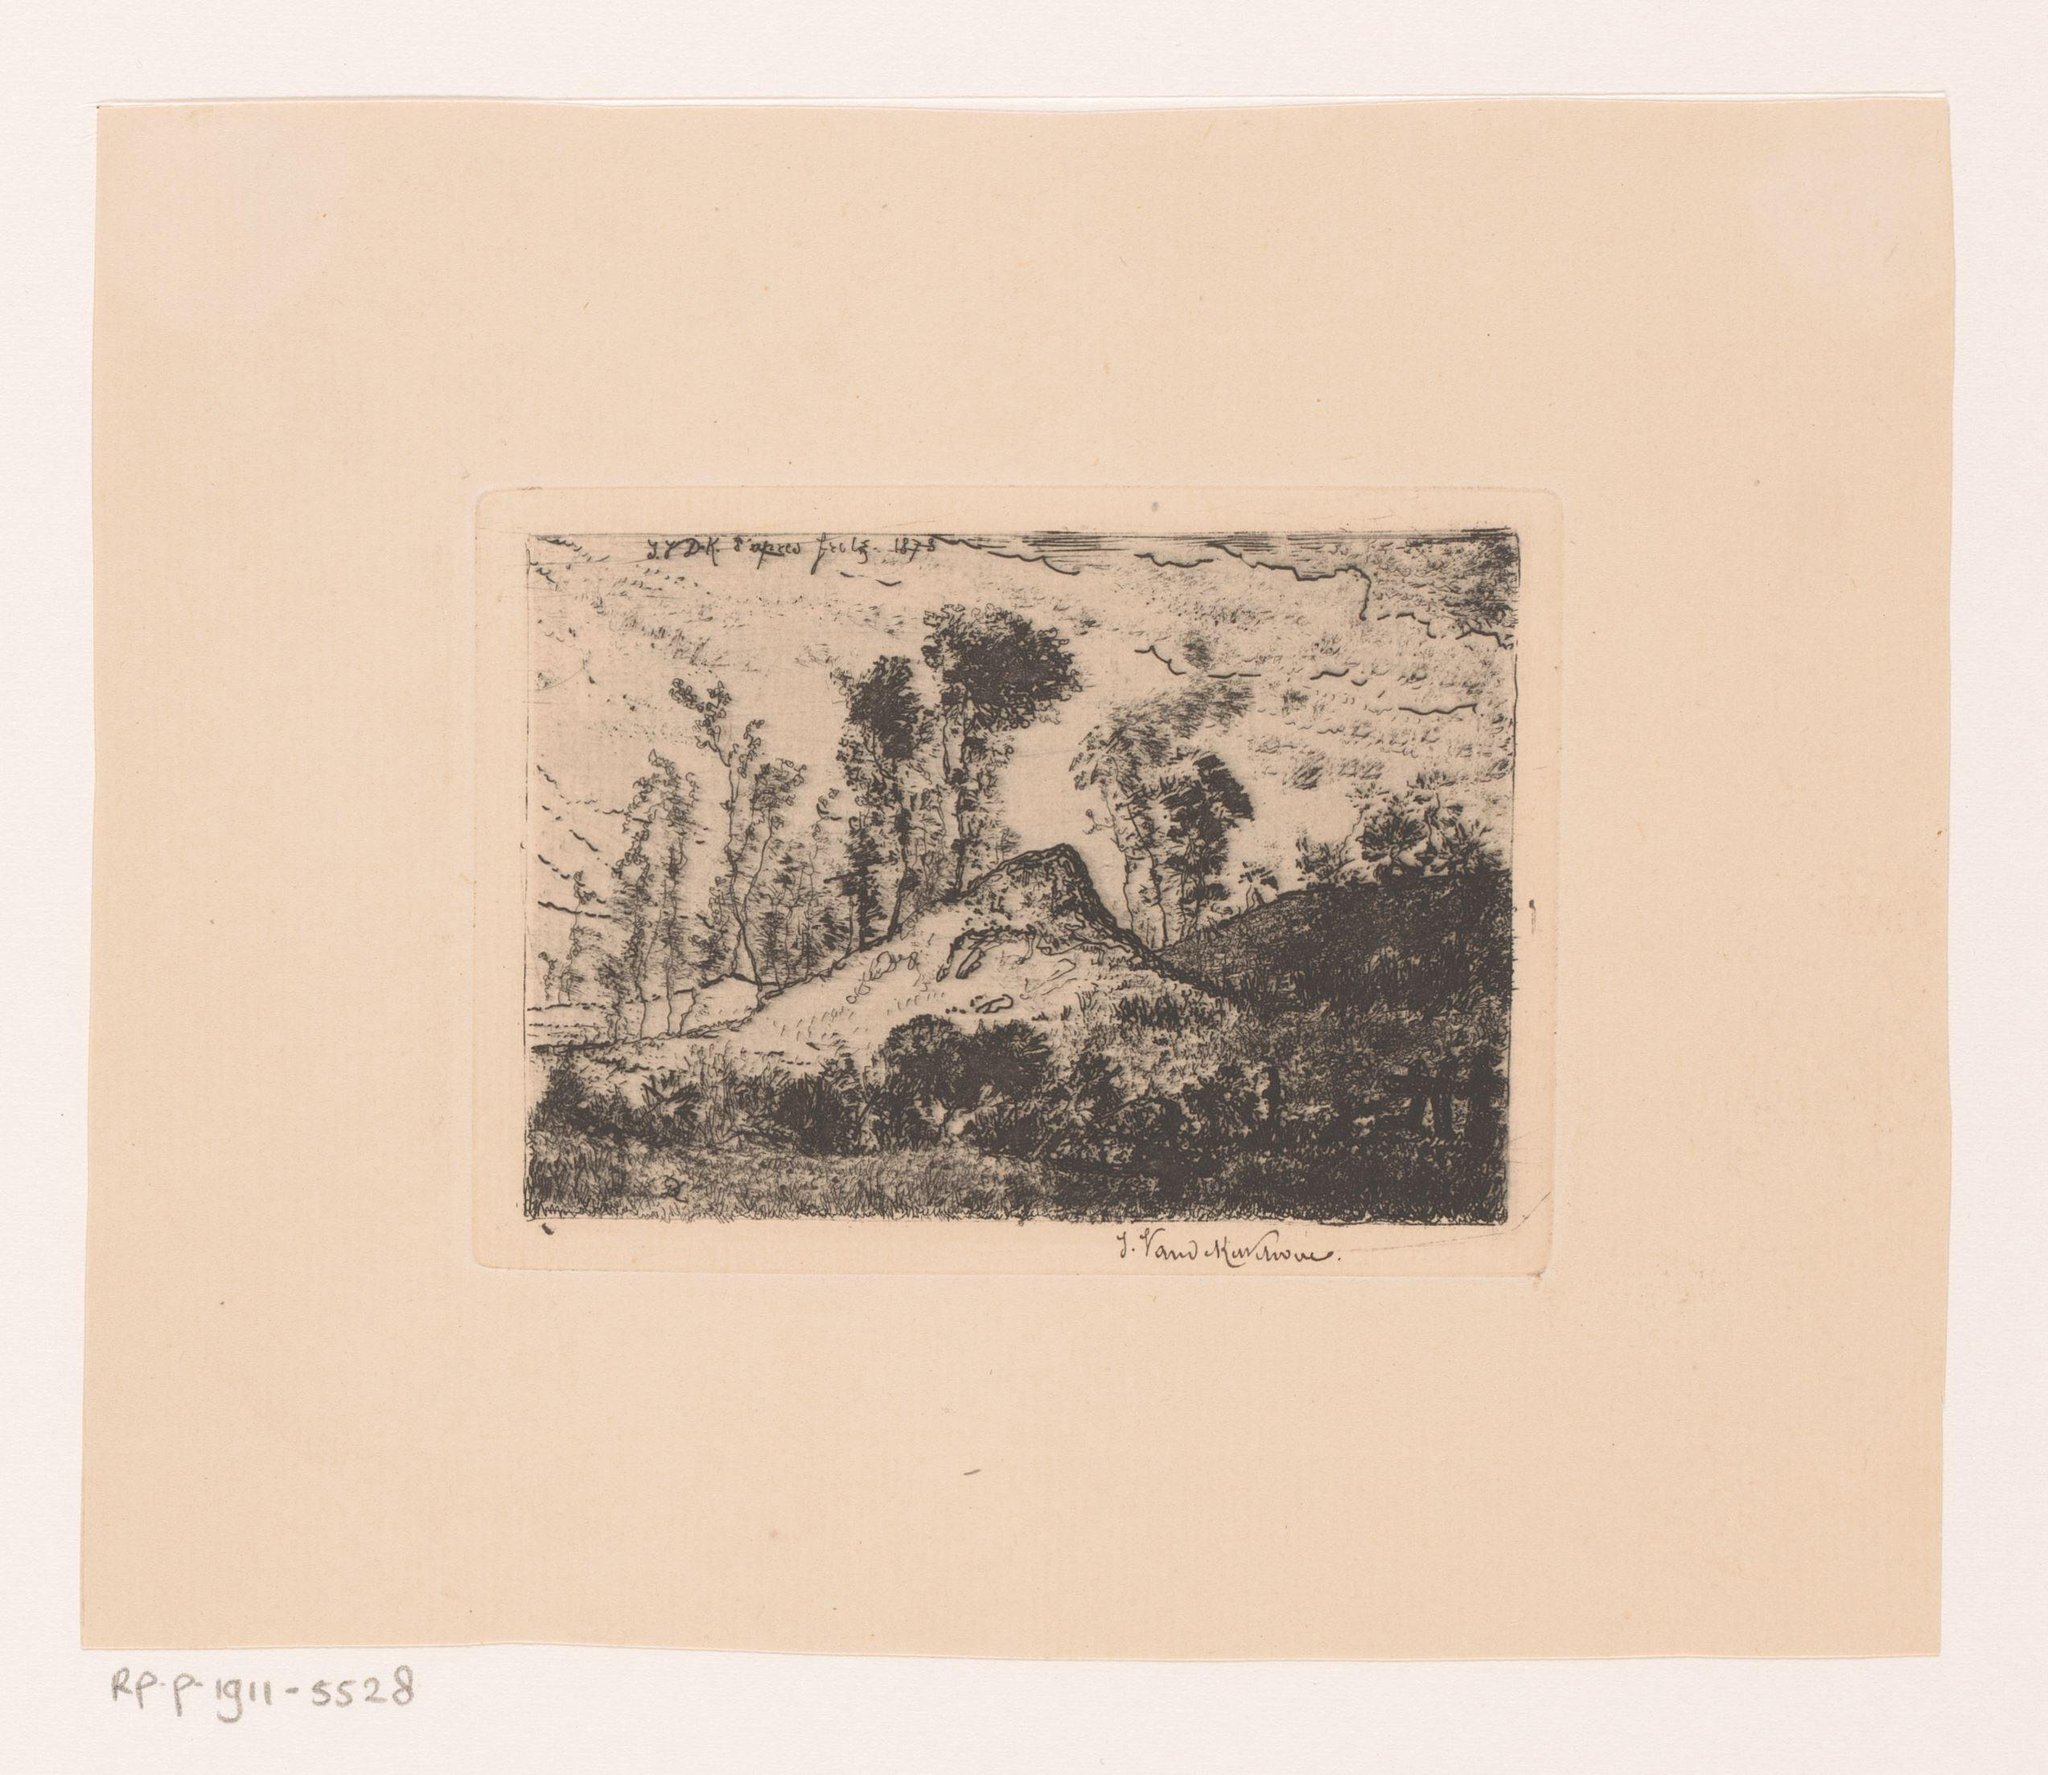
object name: print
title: Heuvelachtig landschap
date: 1873-1881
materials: paper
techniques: drypoint, etching, intaglio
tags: low hill country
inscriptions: collector's mark: Lugt 2228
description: De etsen naar de schilderijen van Frédéric Van de Kerkhove werden na zijn dood door zijn vader en zuster gemaakt en uitgegeven in twee reeksen. De eerste werd in 1877 uitgegeven door het Journal des Beaux-Arts et de la Littérature: Cahier de 25 Eaux-fortes d'après Frédéric van de Kerkhove, gravées par son père et sa sœur. De tweede reeks van 126 etsen, ook in 1877, werd in Parijs uitgegeven bij A. Lévy onder de titel Cent eaux-fortes gravées par J. Van de Kerkhove d'après les tableaux de Frédéric Van de Kerkhove, mort en 1873 à l'âge de 10 ans et 11 mois.